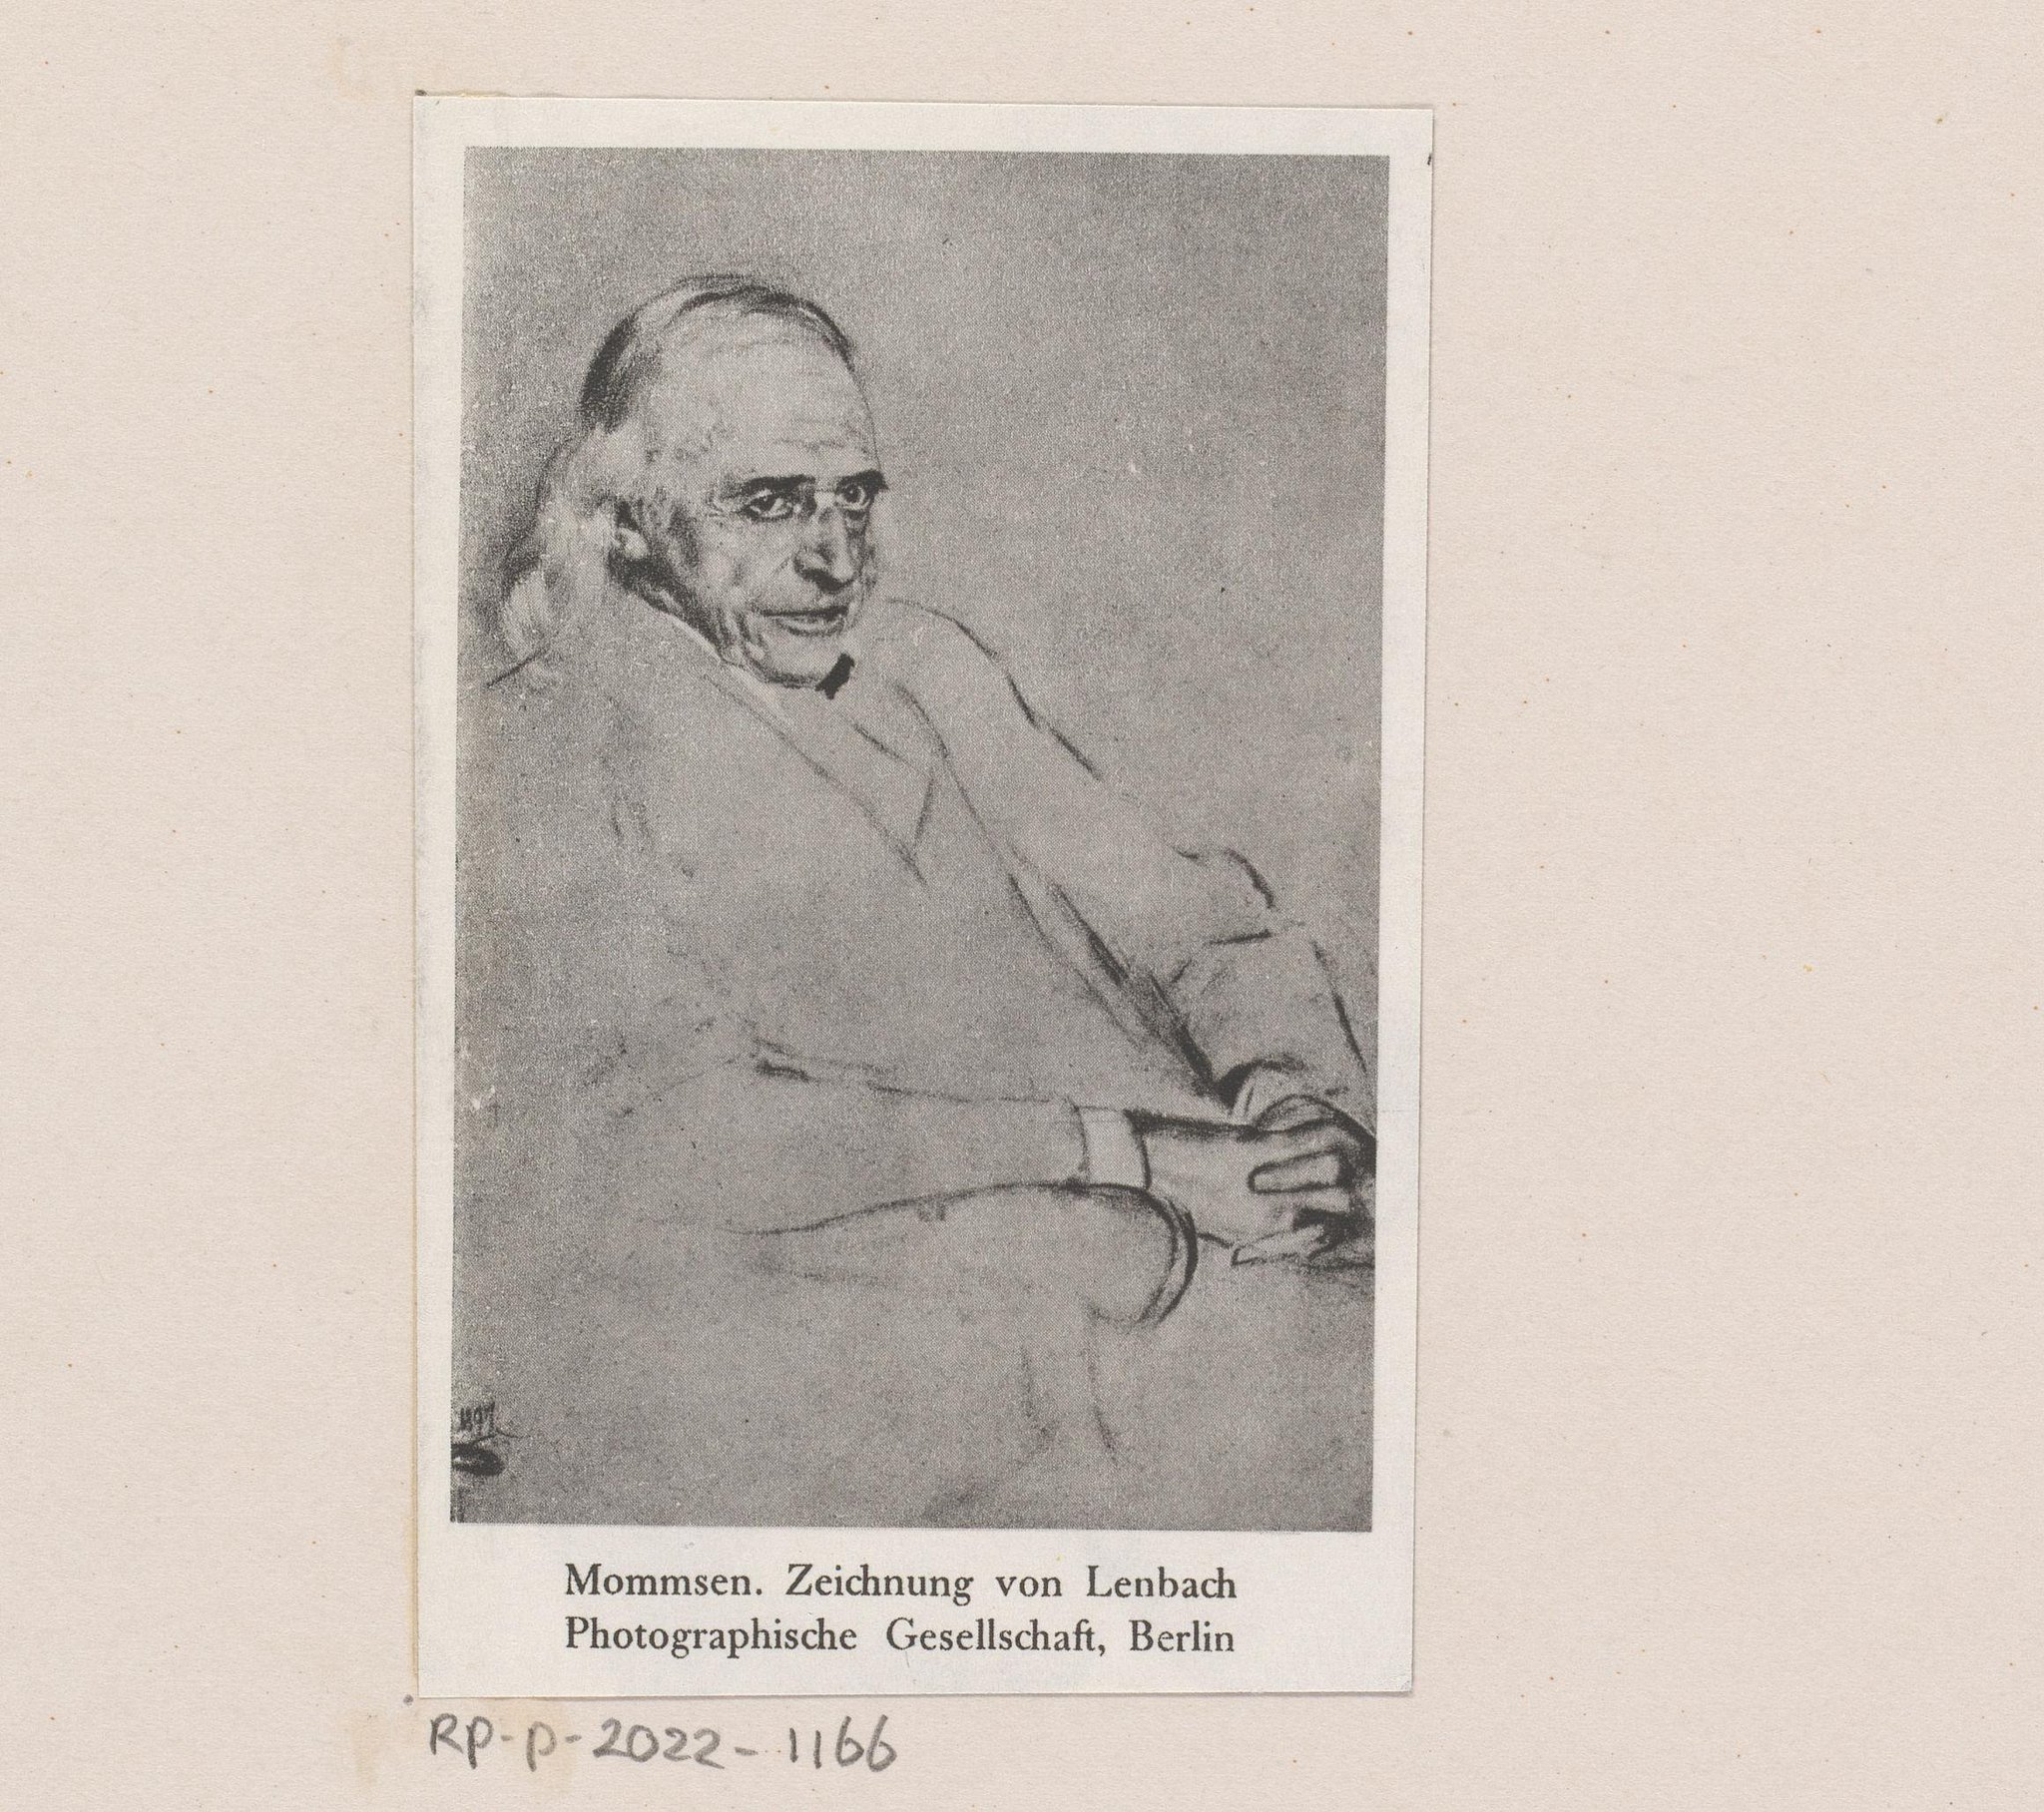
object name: photomechanical print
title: Portret van Theodor Mommsen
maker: Anonymous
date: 1875-1930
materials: paper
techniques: photograph, letterpress printing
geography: berlin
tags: historical persons